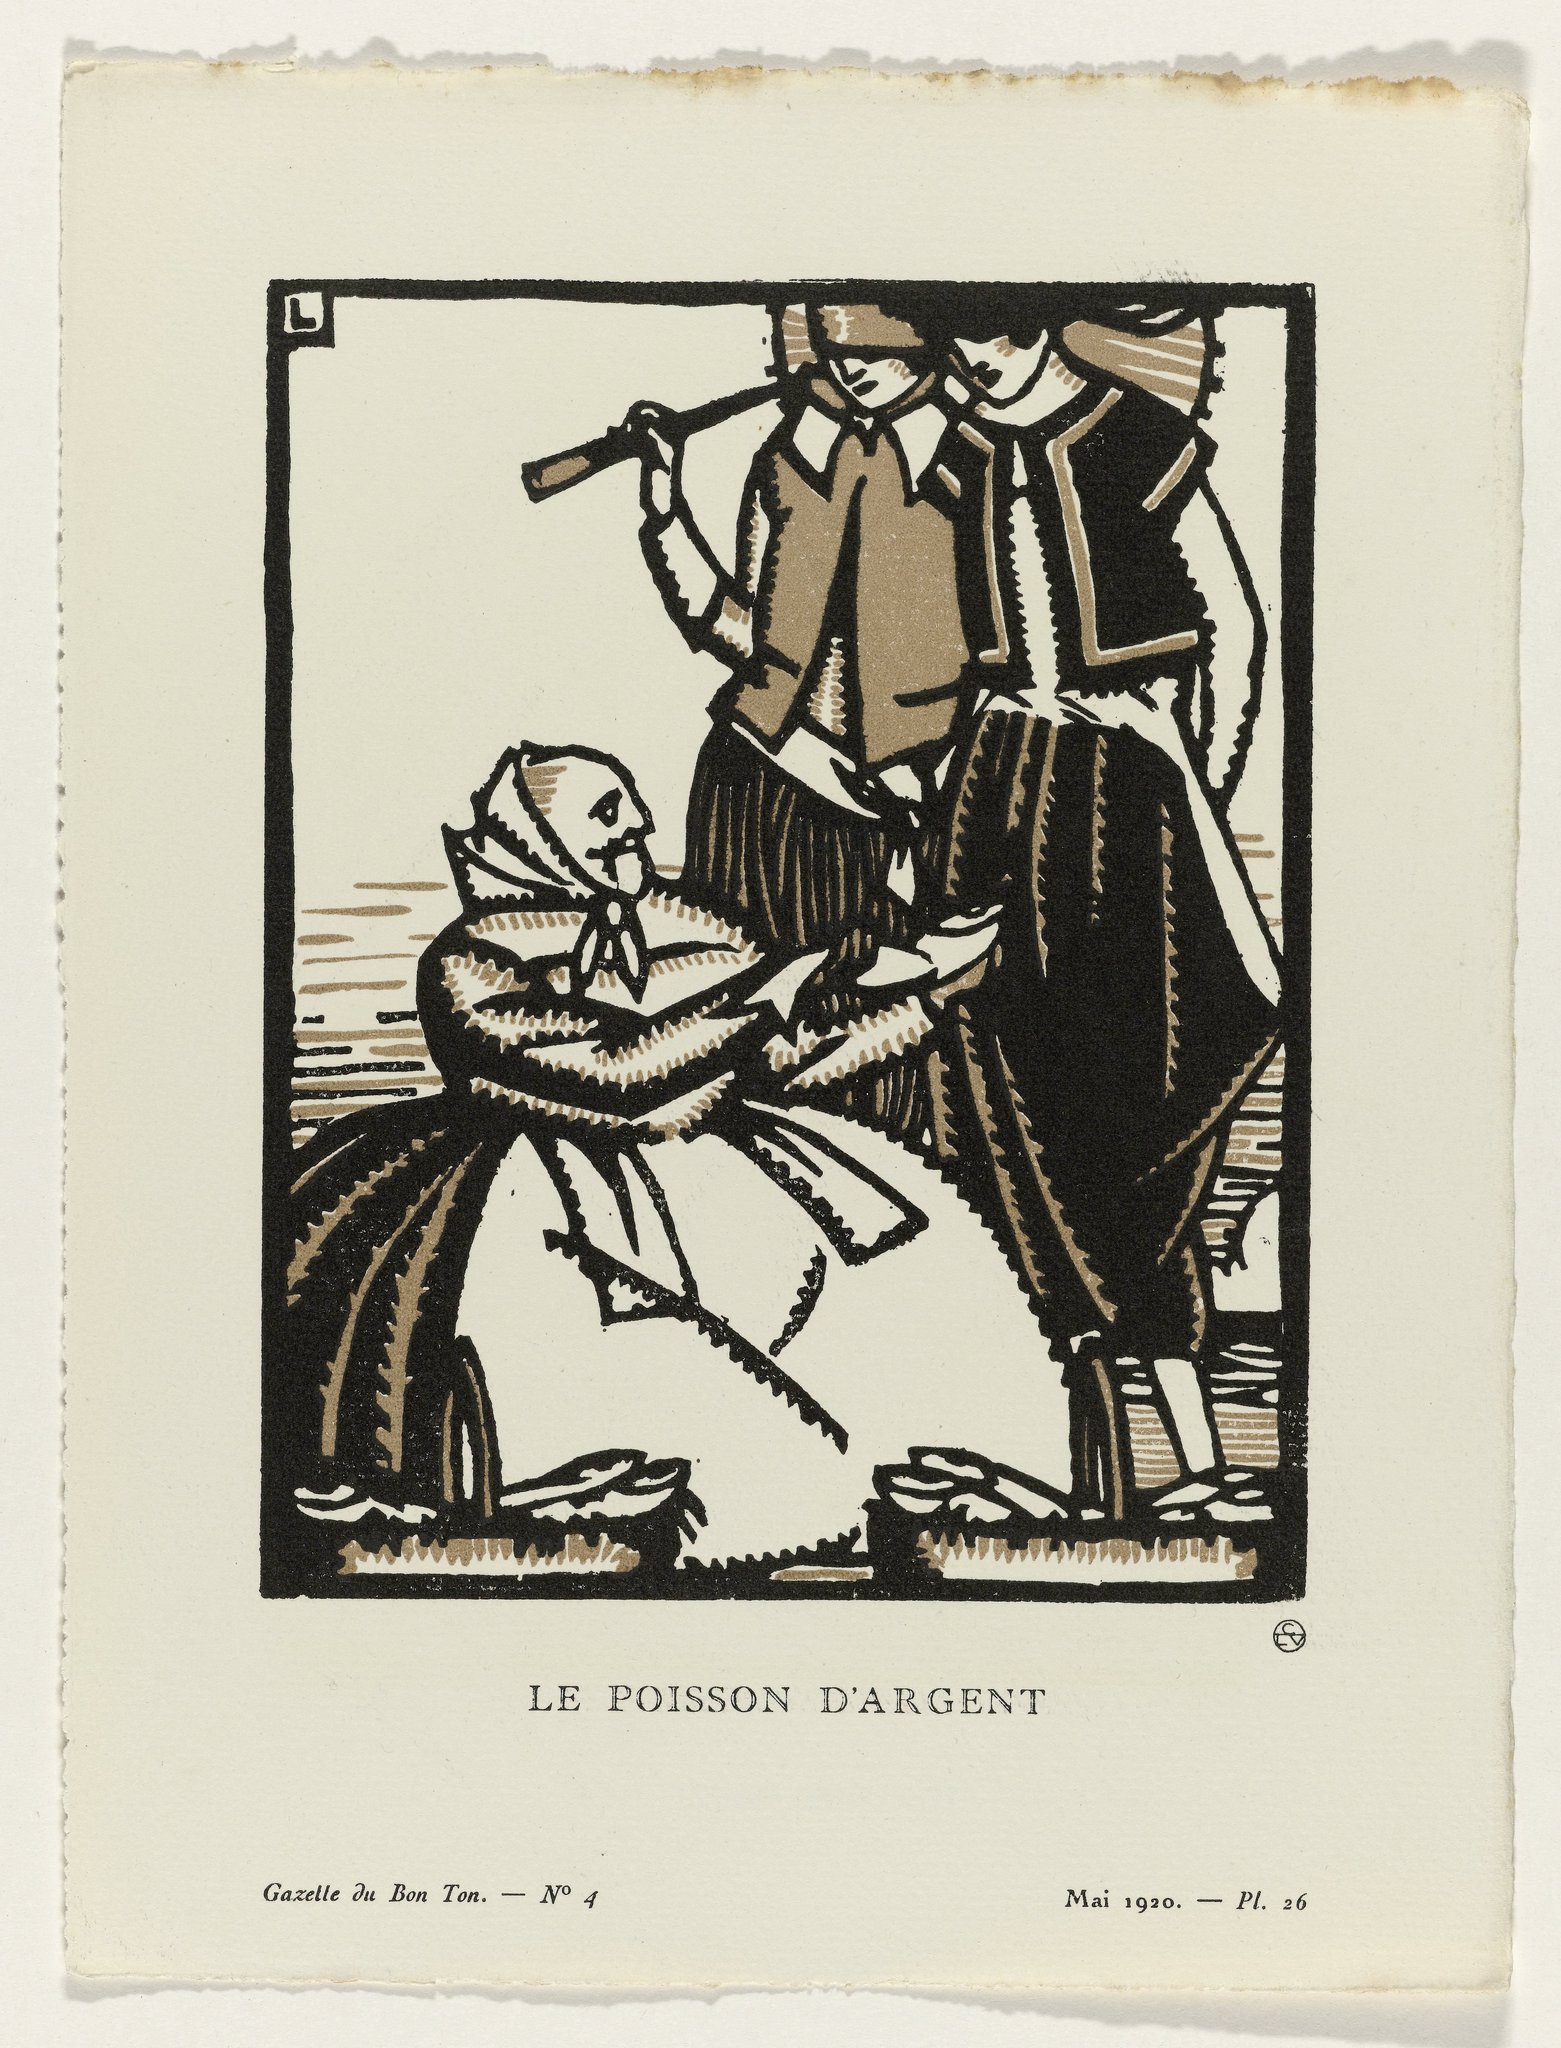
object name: fashion print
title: Gazette du Bon Ton, 1920 - No. 4, Pl. 26: Le poisson d'argent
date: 1920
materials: paper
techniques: letterpress printing, pochoir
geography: geneva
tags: head-gear (+ women's clothes), fishes, fashion plates, dress, gown (+ women's clothes), parasol, sunshade (+ women's clothes)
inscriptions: date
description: Twee staande vrouwen aan zee, gekleed in middagjaponnen, met een parasol in de hand. Links zit een vissersvrouw op de grond. Planche 26 uit Gazette du Bon Ton 1920, No. 4. Uitleg over de kleding op pagina "Explication des Planches".